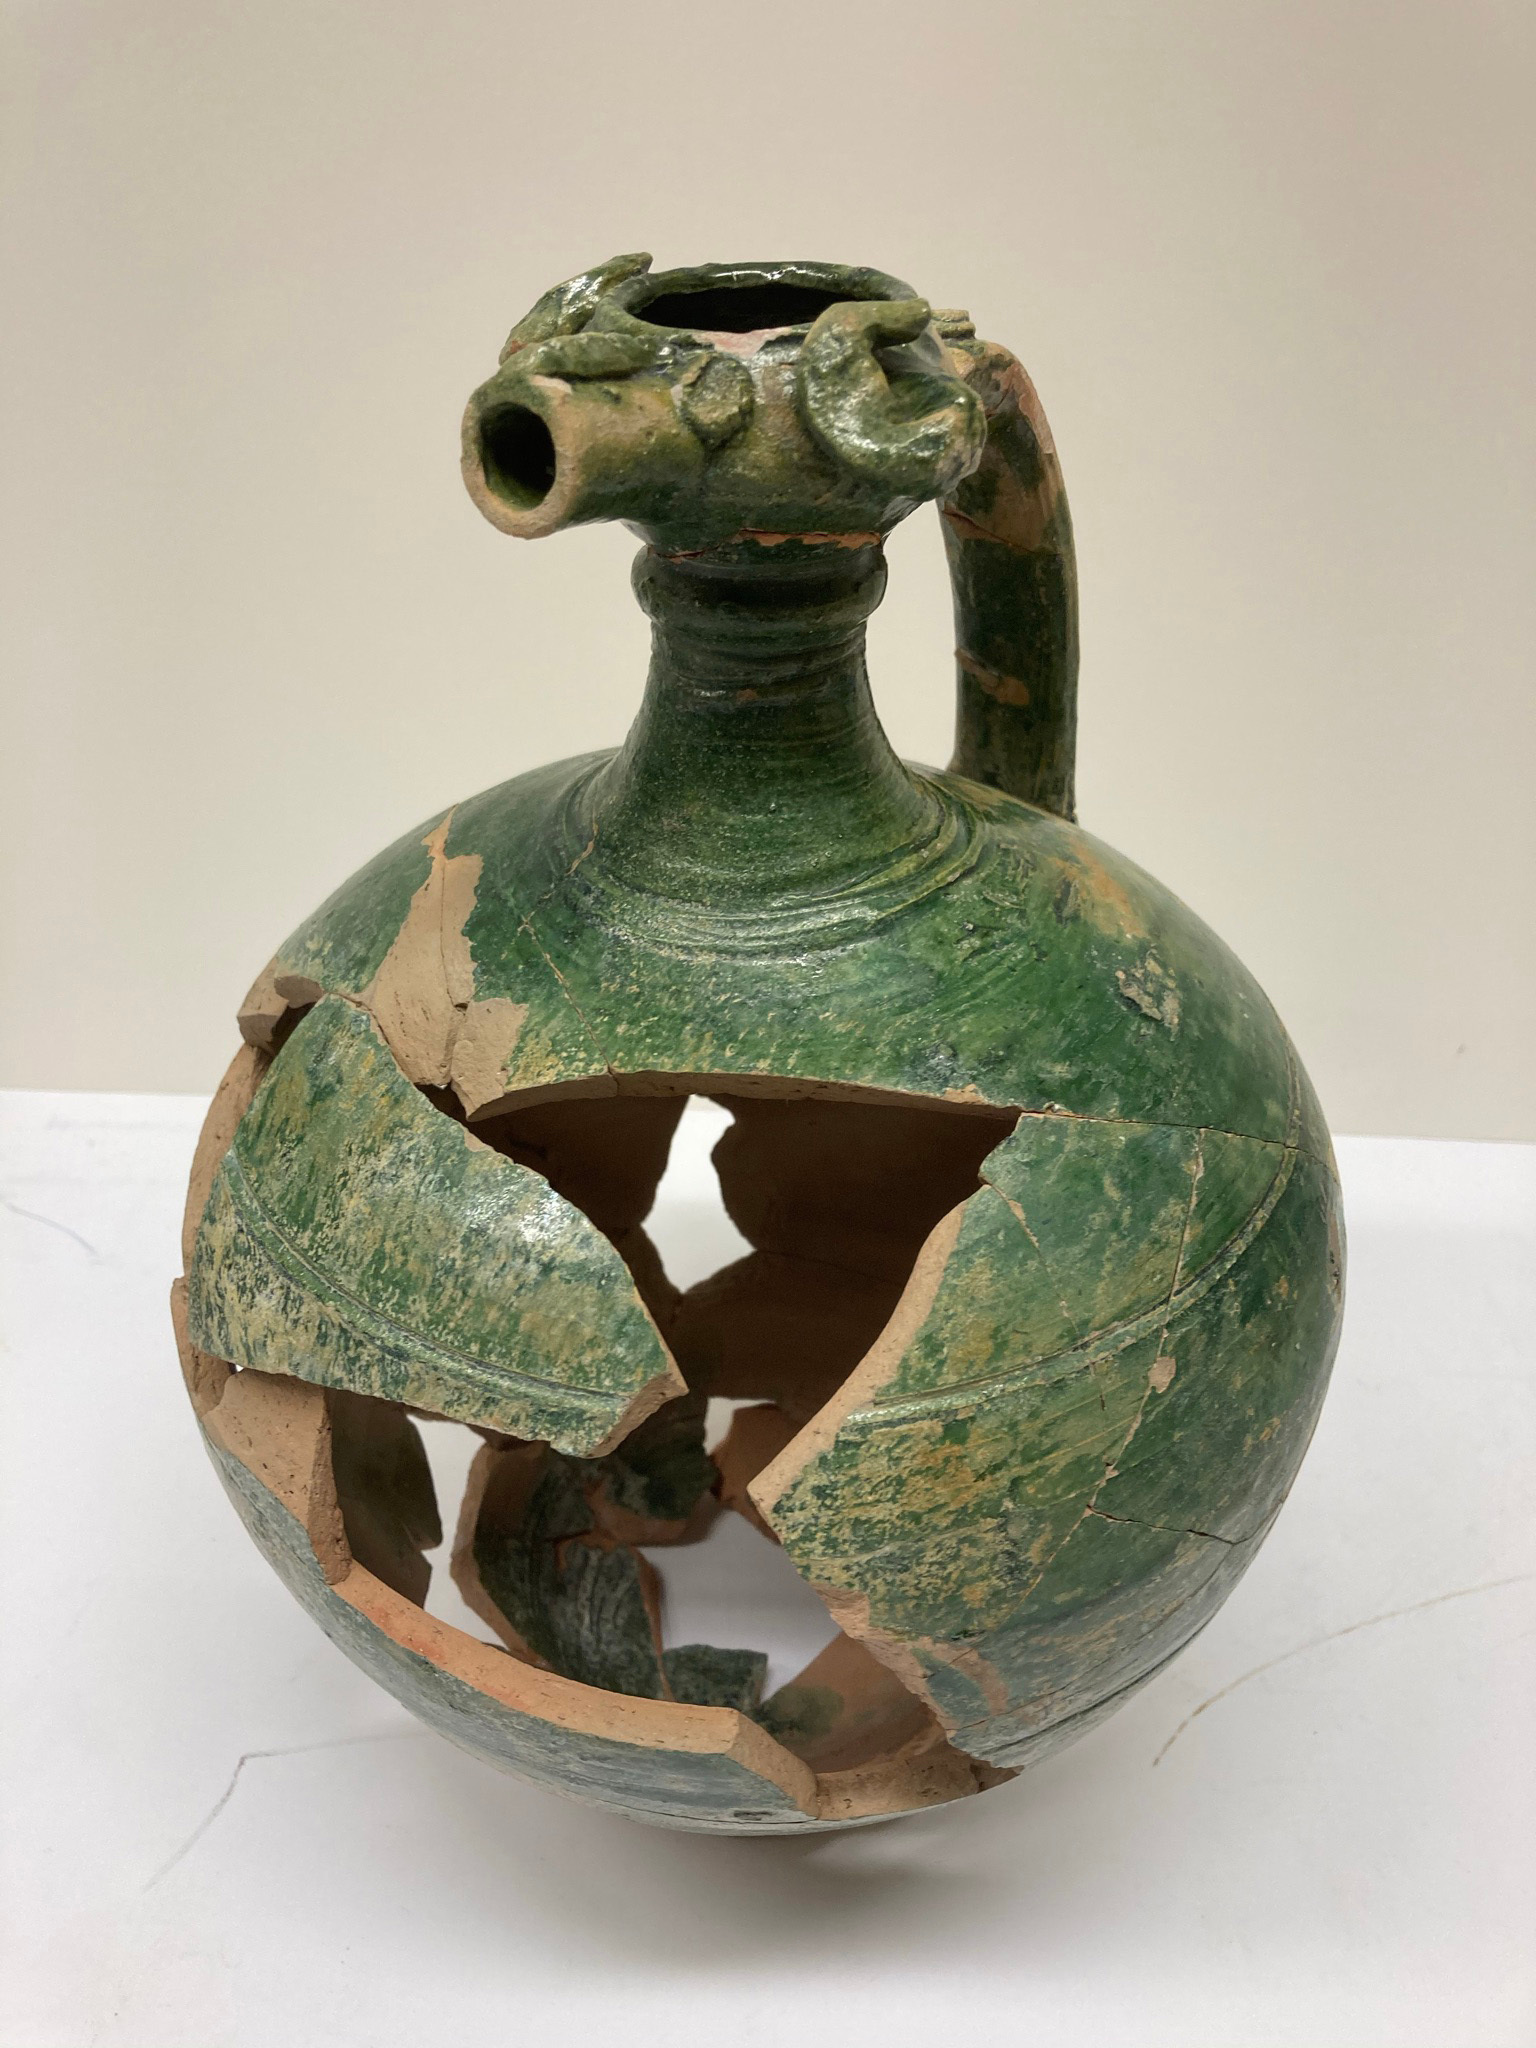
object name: ewer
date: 801-1000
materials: earthenware, glaze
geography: iran